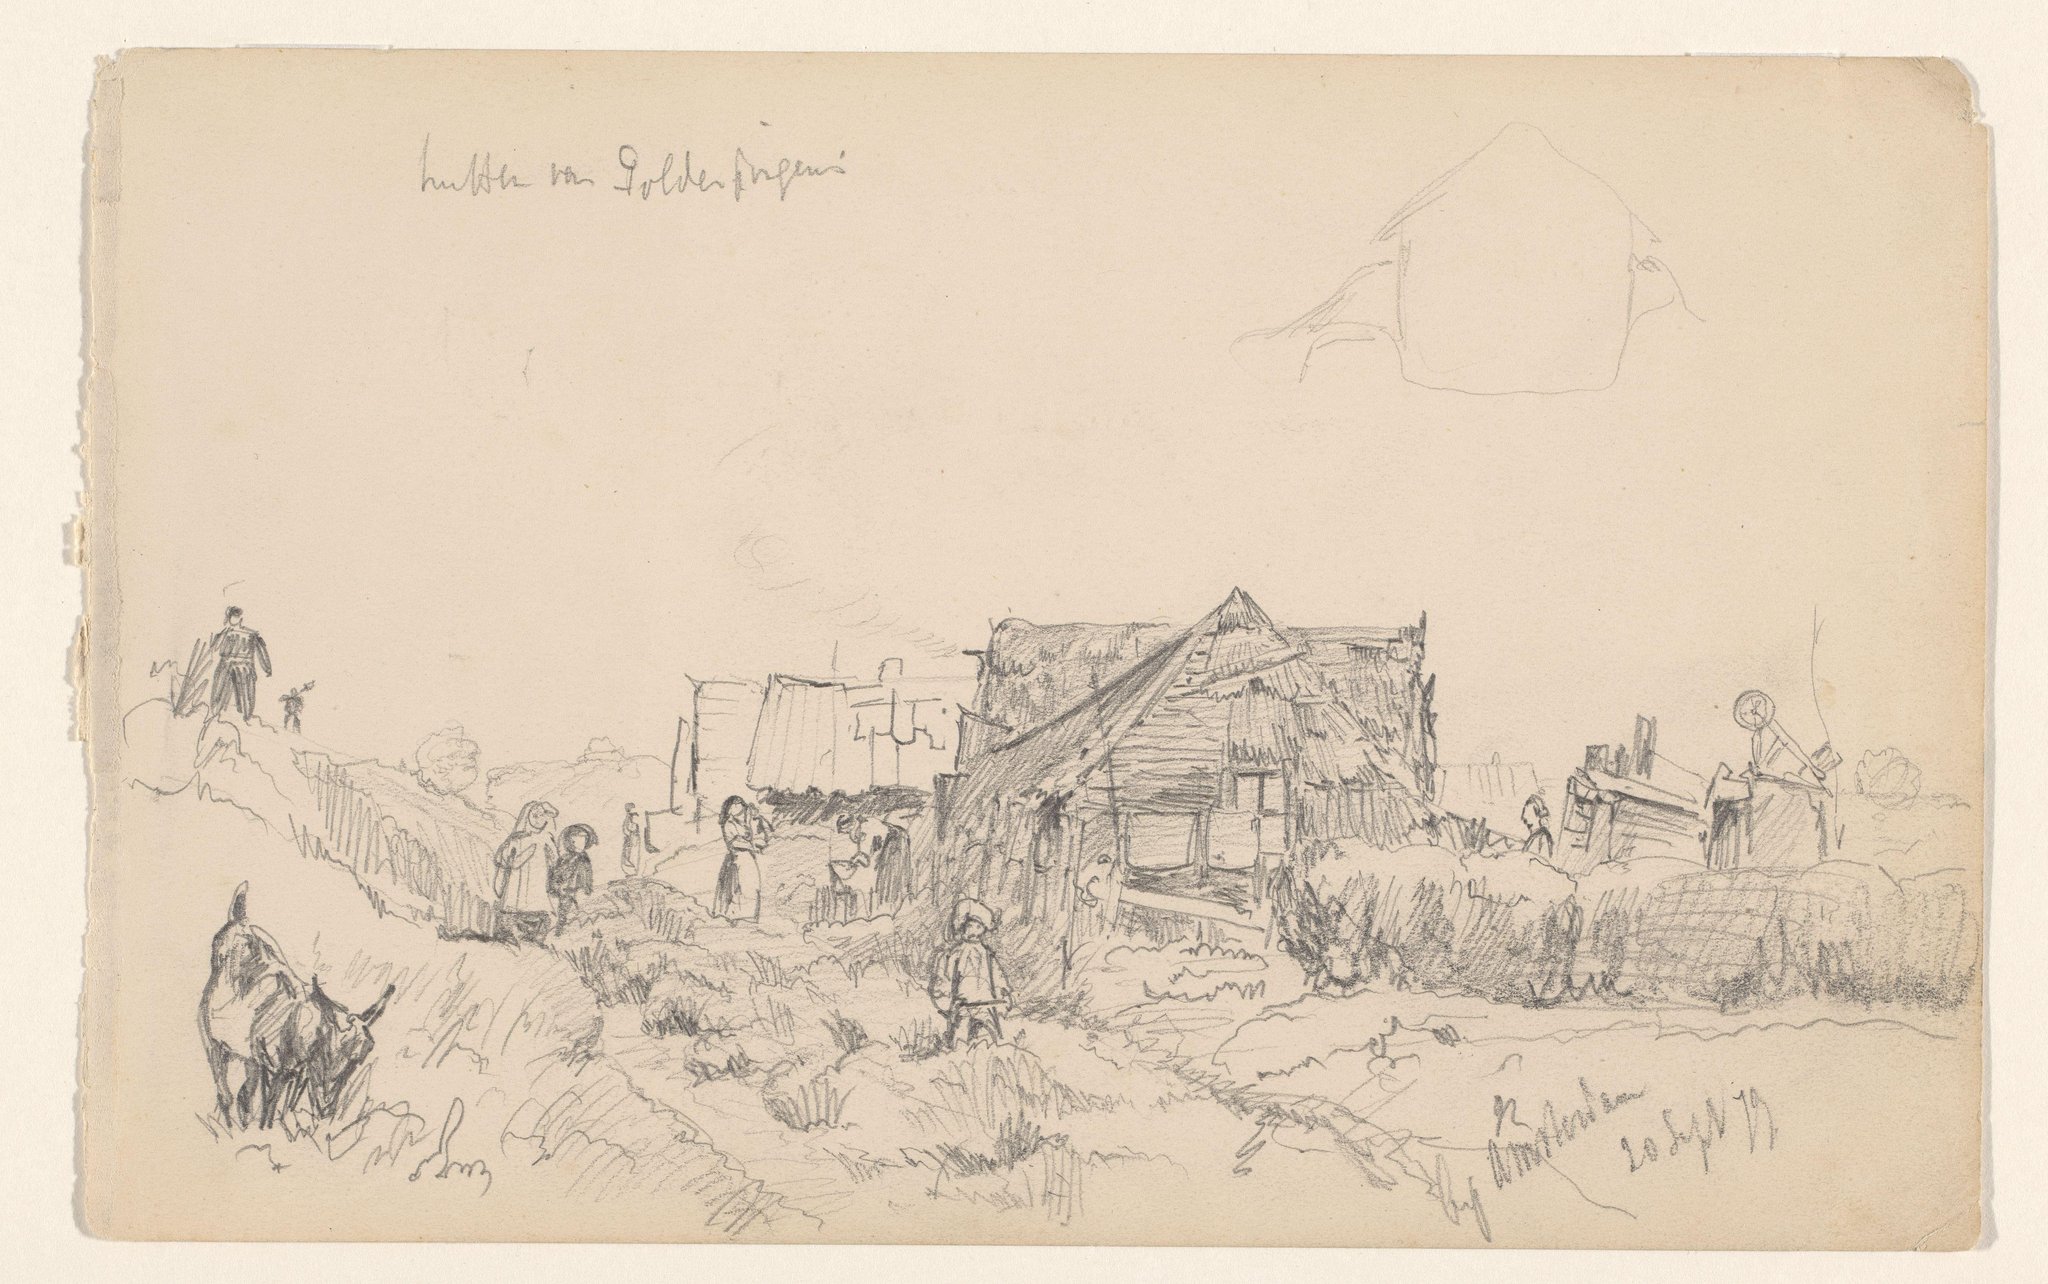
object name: drawing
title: Landschap met hutten bij Amsterdam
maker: jan hoynck van papendrecht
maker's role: draughtsman, painter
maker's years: 1858-1933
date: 1879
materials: paper, pencil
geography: north holland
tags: hut, cabin, lodge, landscapes (+ landscape with figures, staffage)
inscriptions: annotation: ‘hutten van Polderjongens/ bij Amsterdam 20 Sept 79’, collector's mark: Lugt 2228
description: Rondom de hutten lopen en werken figuren.